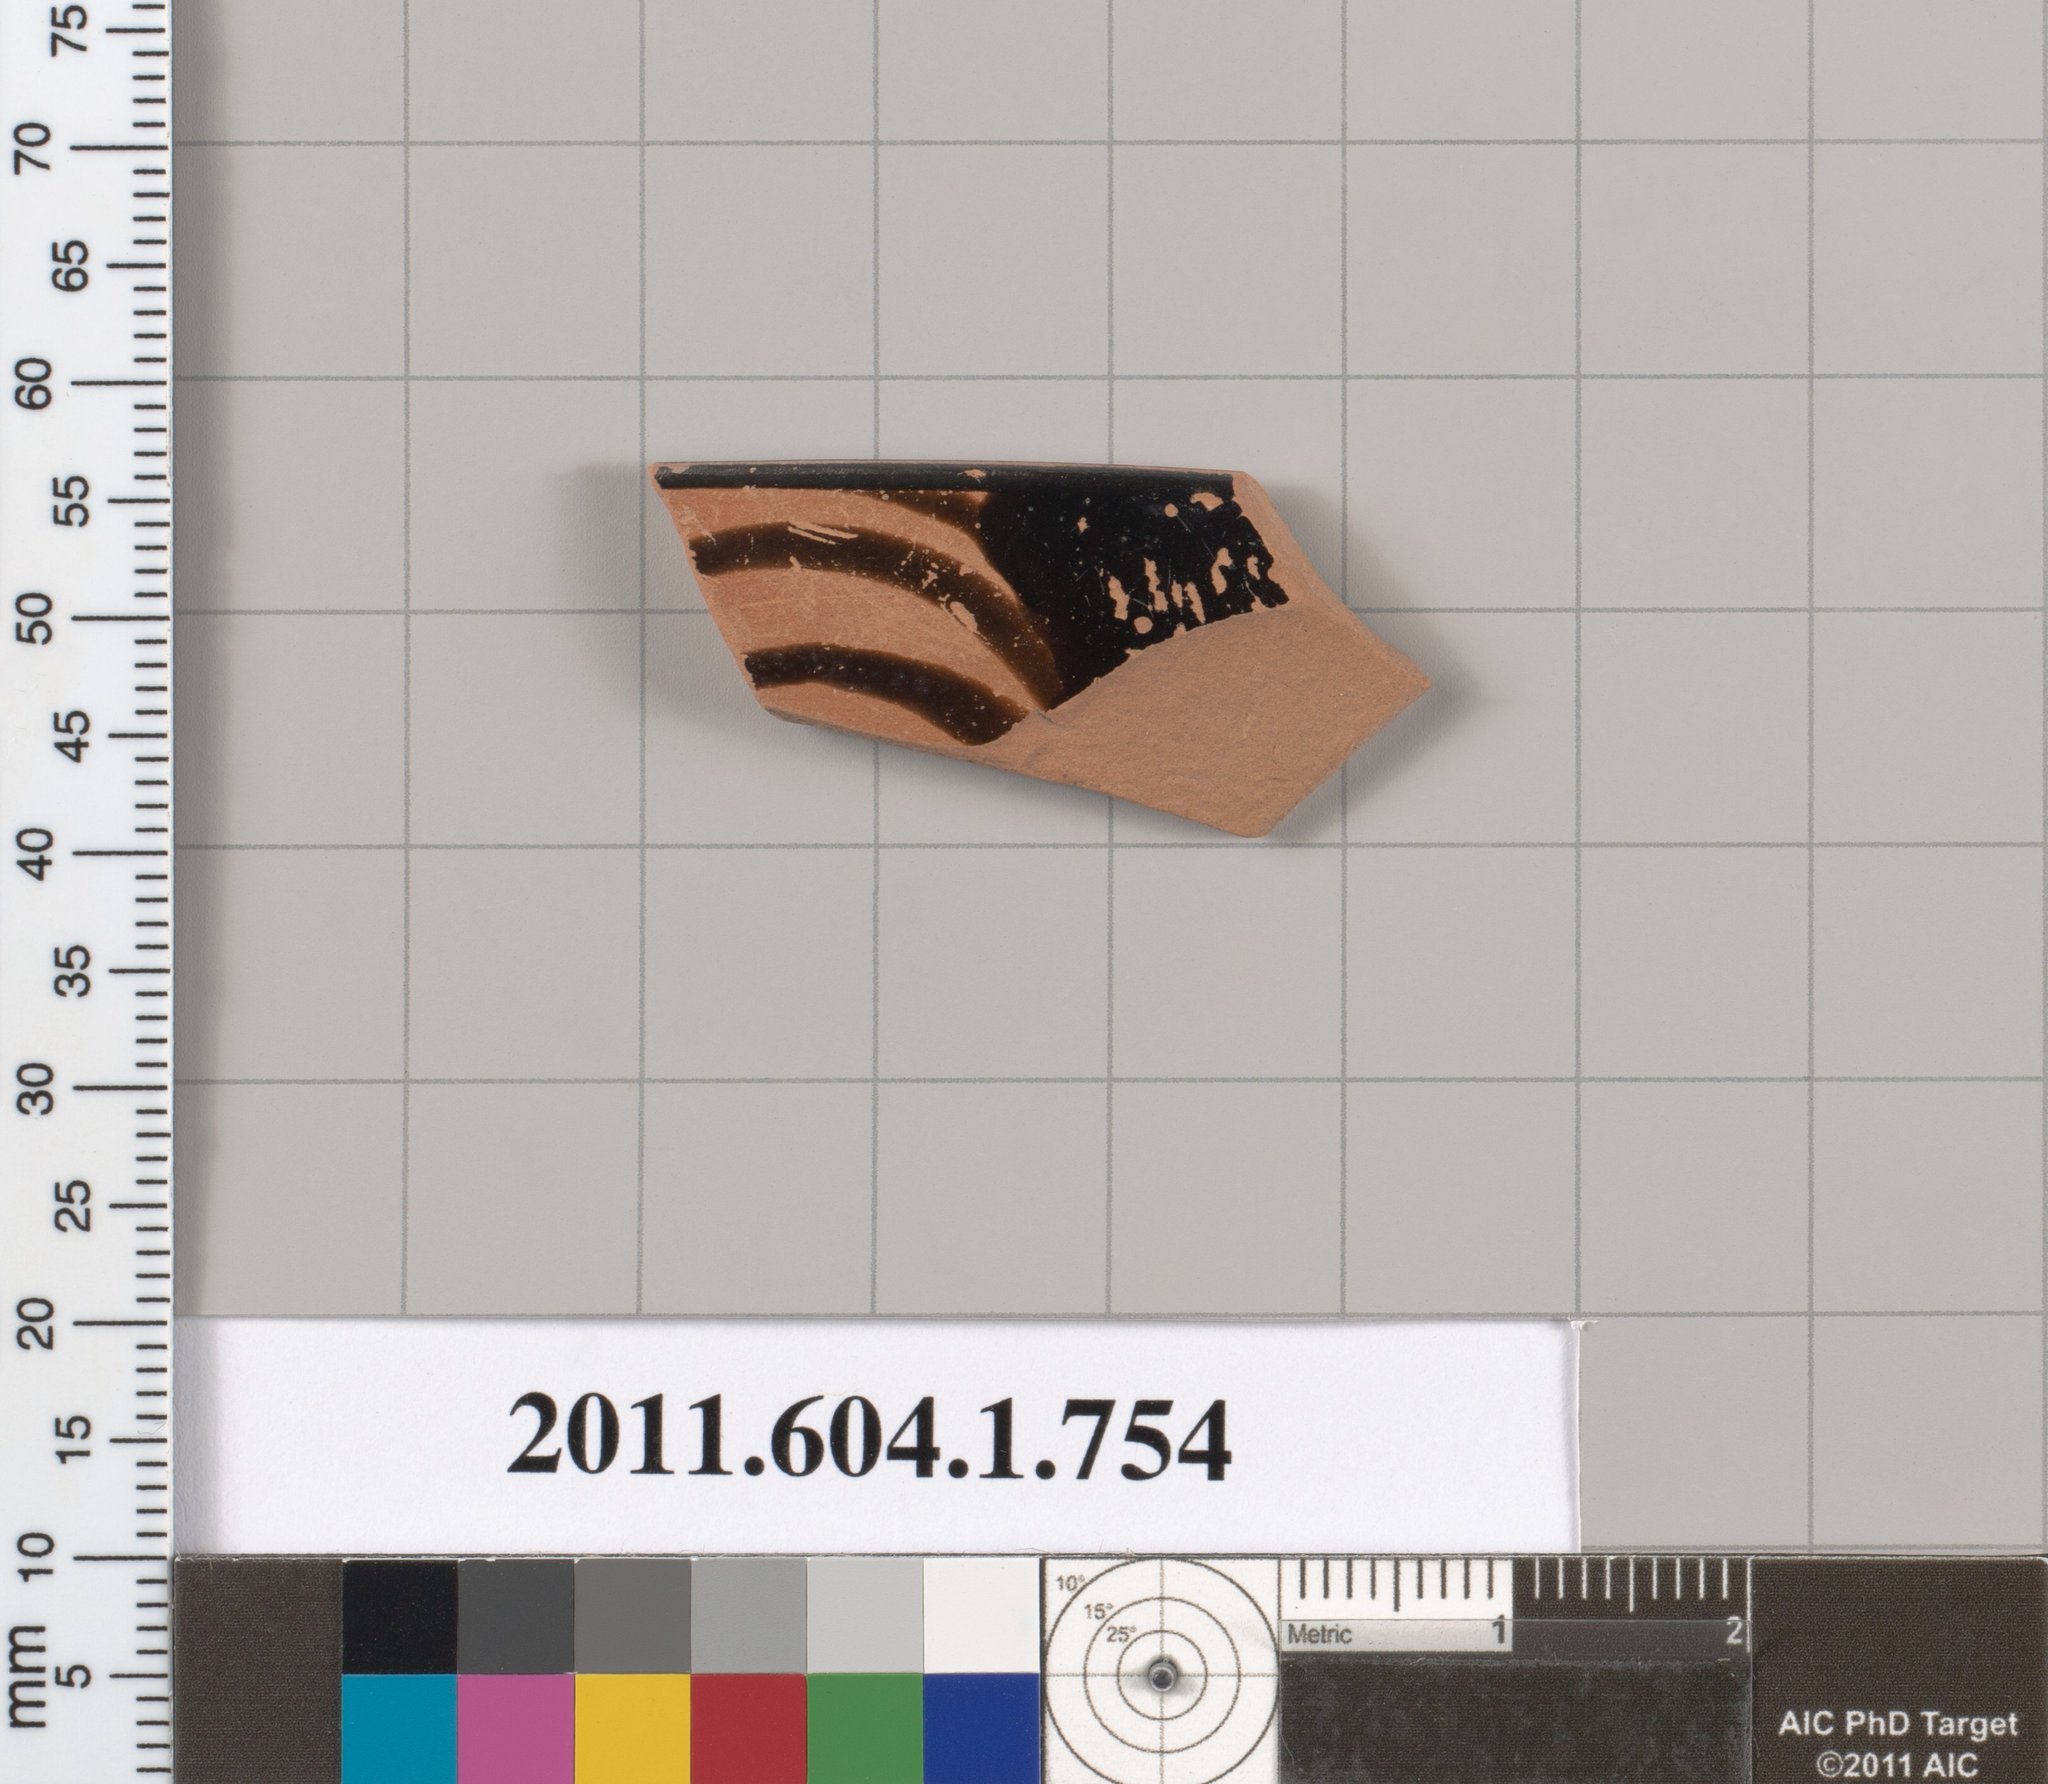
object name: kylix fragment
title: Terracotta rim fragment of a kylix (drinking cup)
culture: greek, attic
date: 475-451 BCE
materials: terracotta